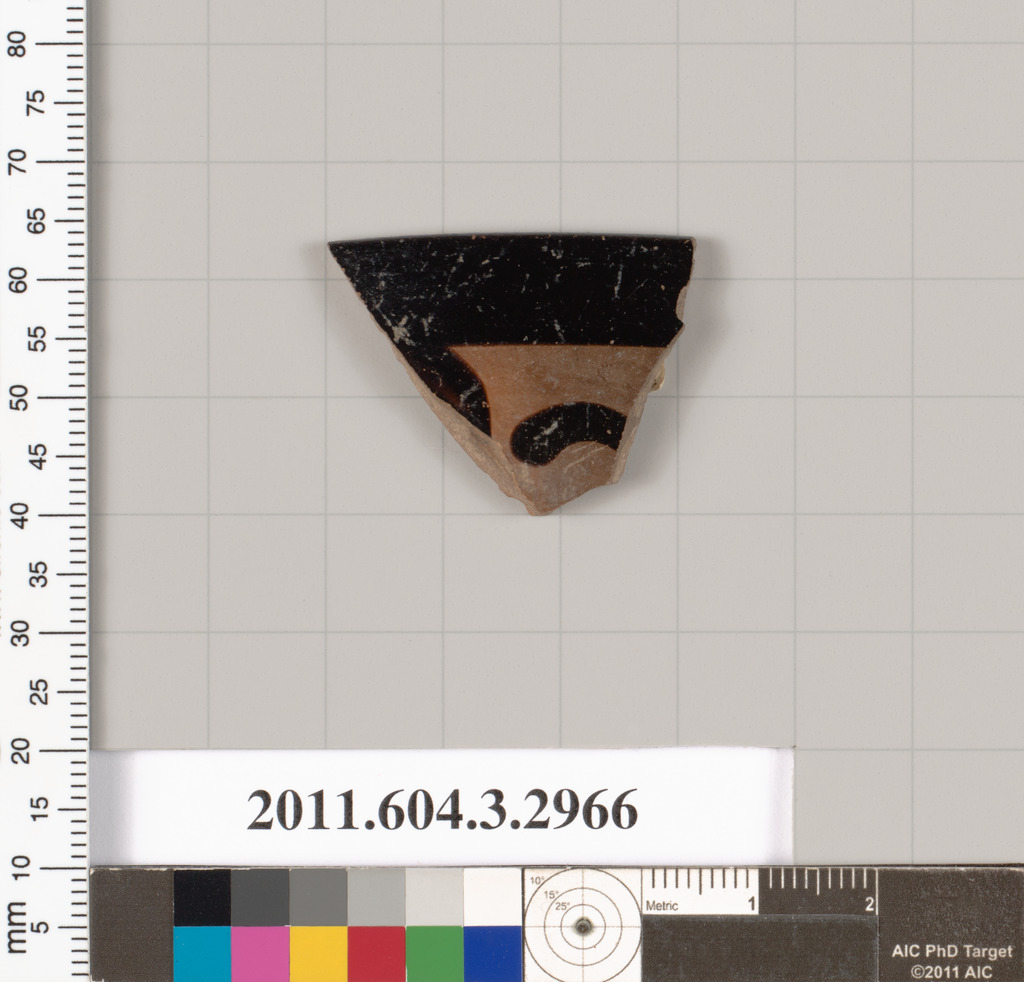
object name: cup skyphos fragment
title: Terracotta rim fragment of a cup-skyphos (drinking cup)?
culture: greek, attic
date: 534-501 BCE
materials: terracotta